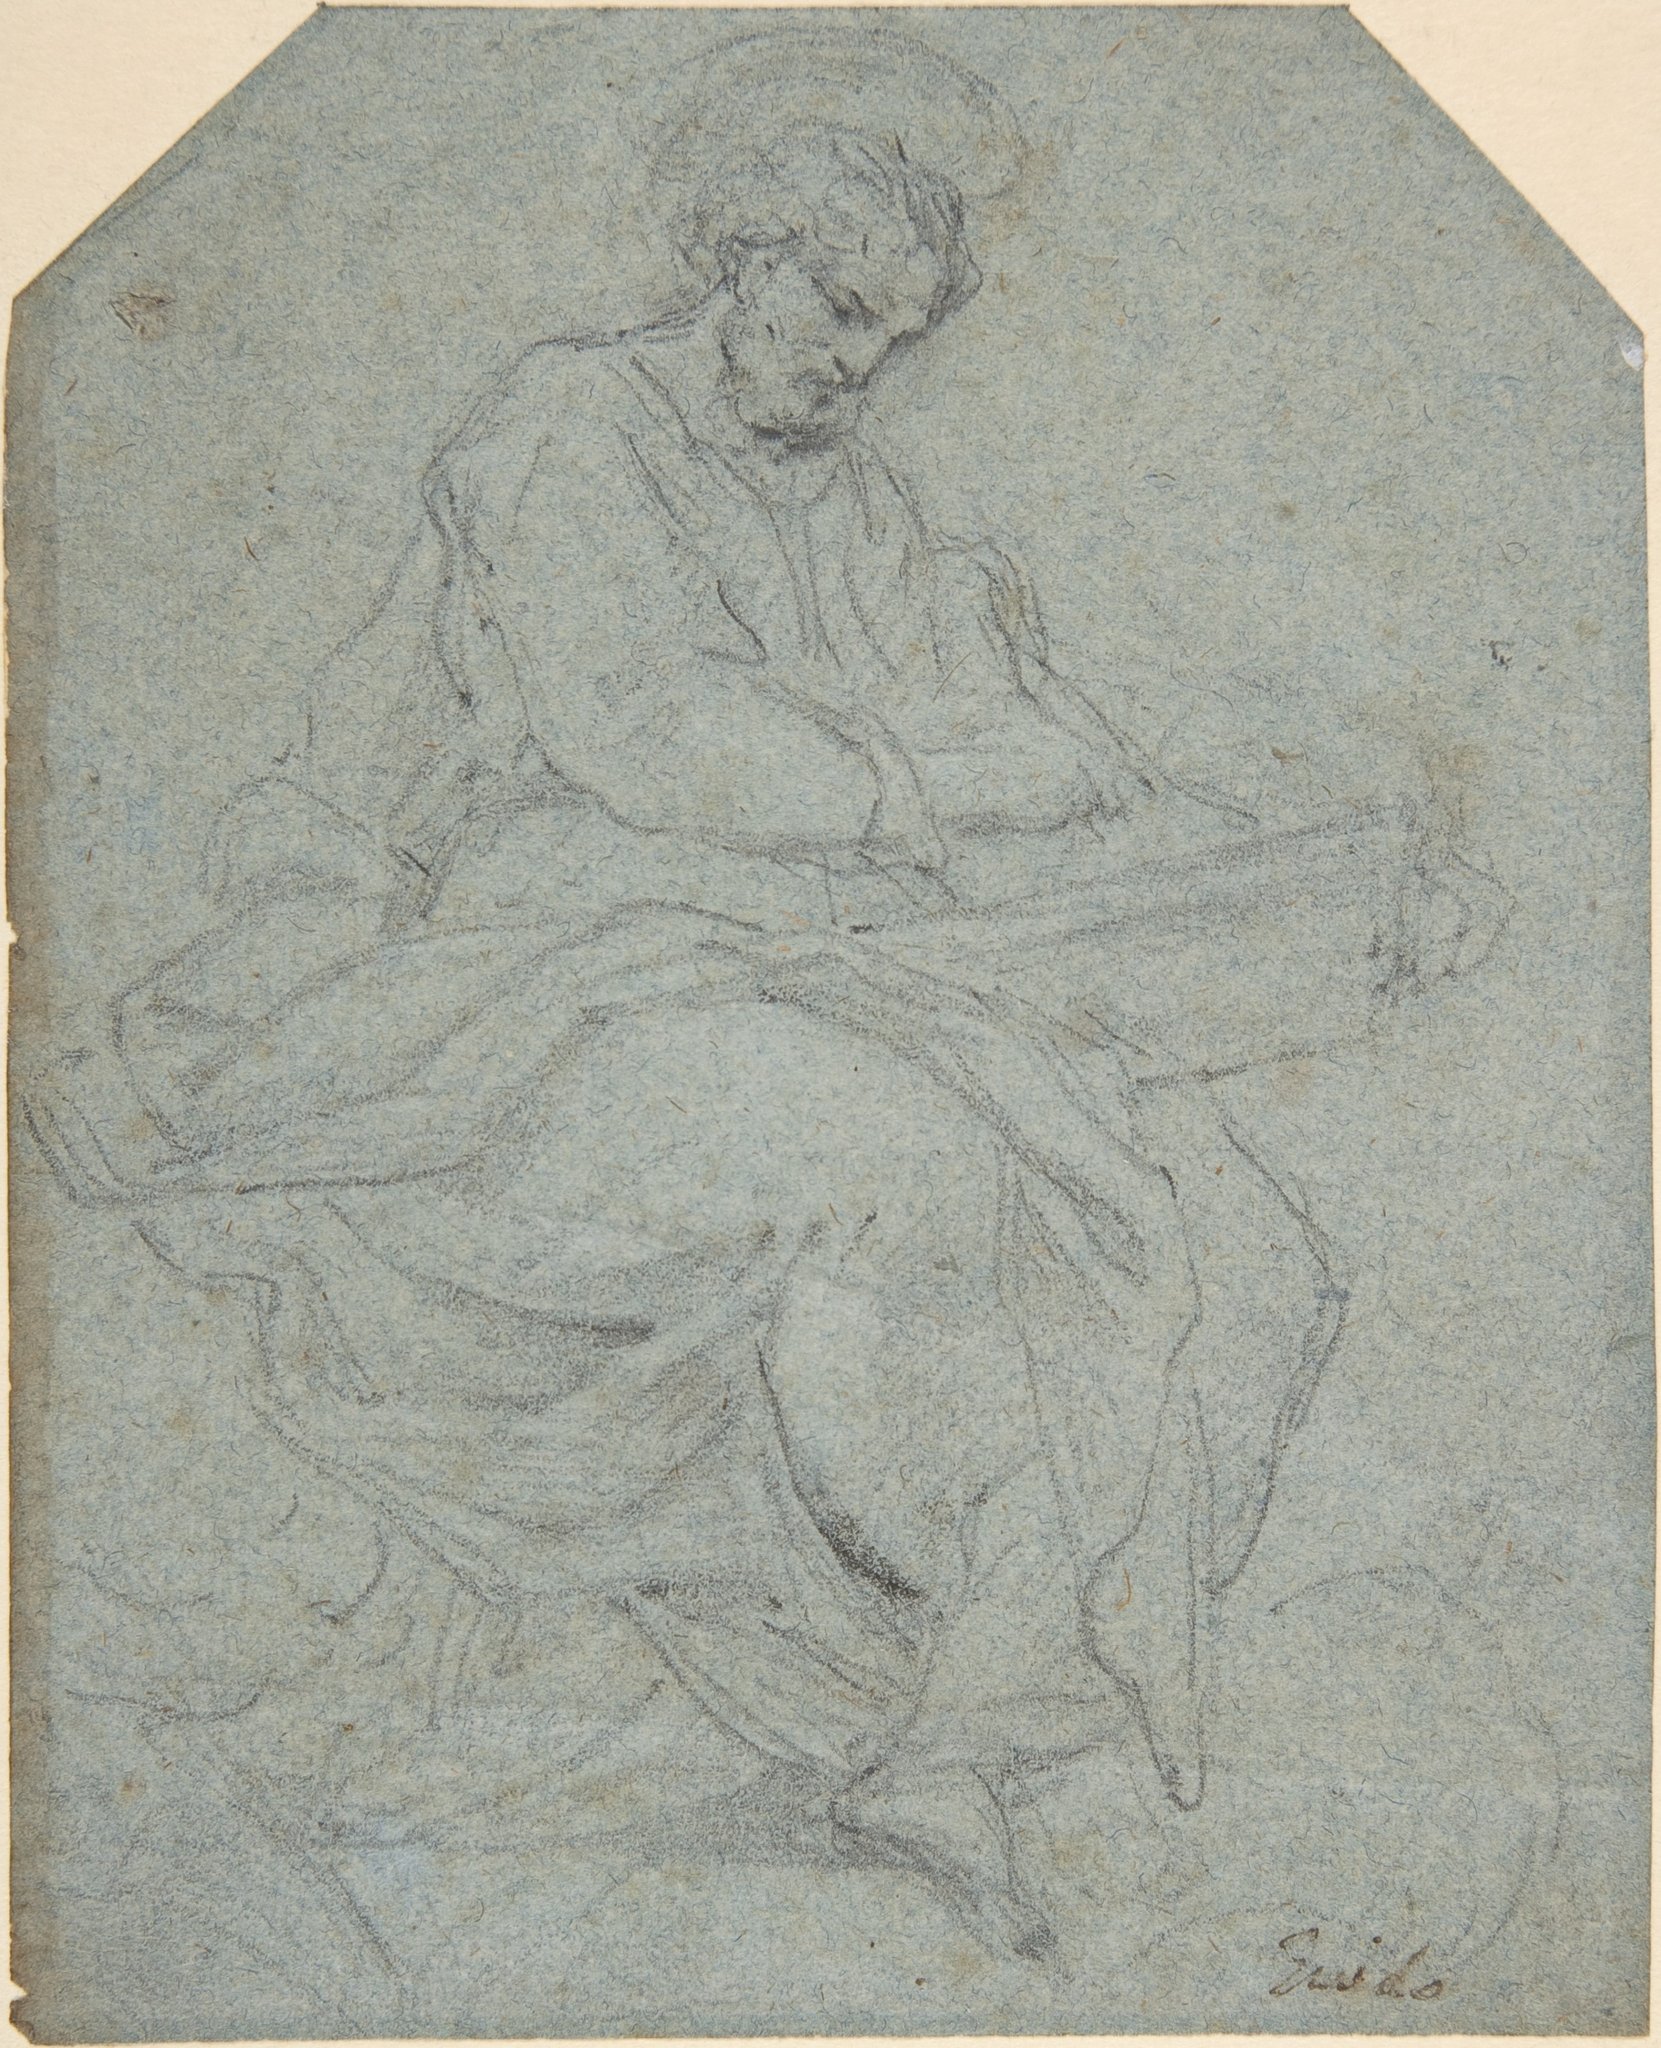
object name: drawing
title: A Seated Apostle (recto); Drapery Study (verso)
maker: anonymous, french, 18th century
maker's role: artist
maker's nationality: french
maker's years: 1700-1800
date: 1701-1800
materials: chalk, paper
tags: apostles